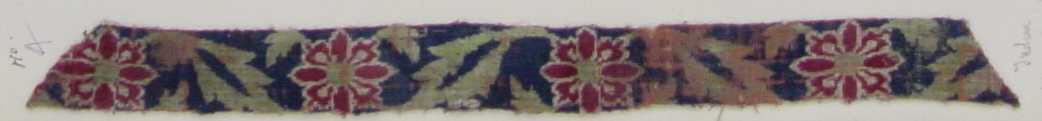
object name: textile fragment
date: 1701-1800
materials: silk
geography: india